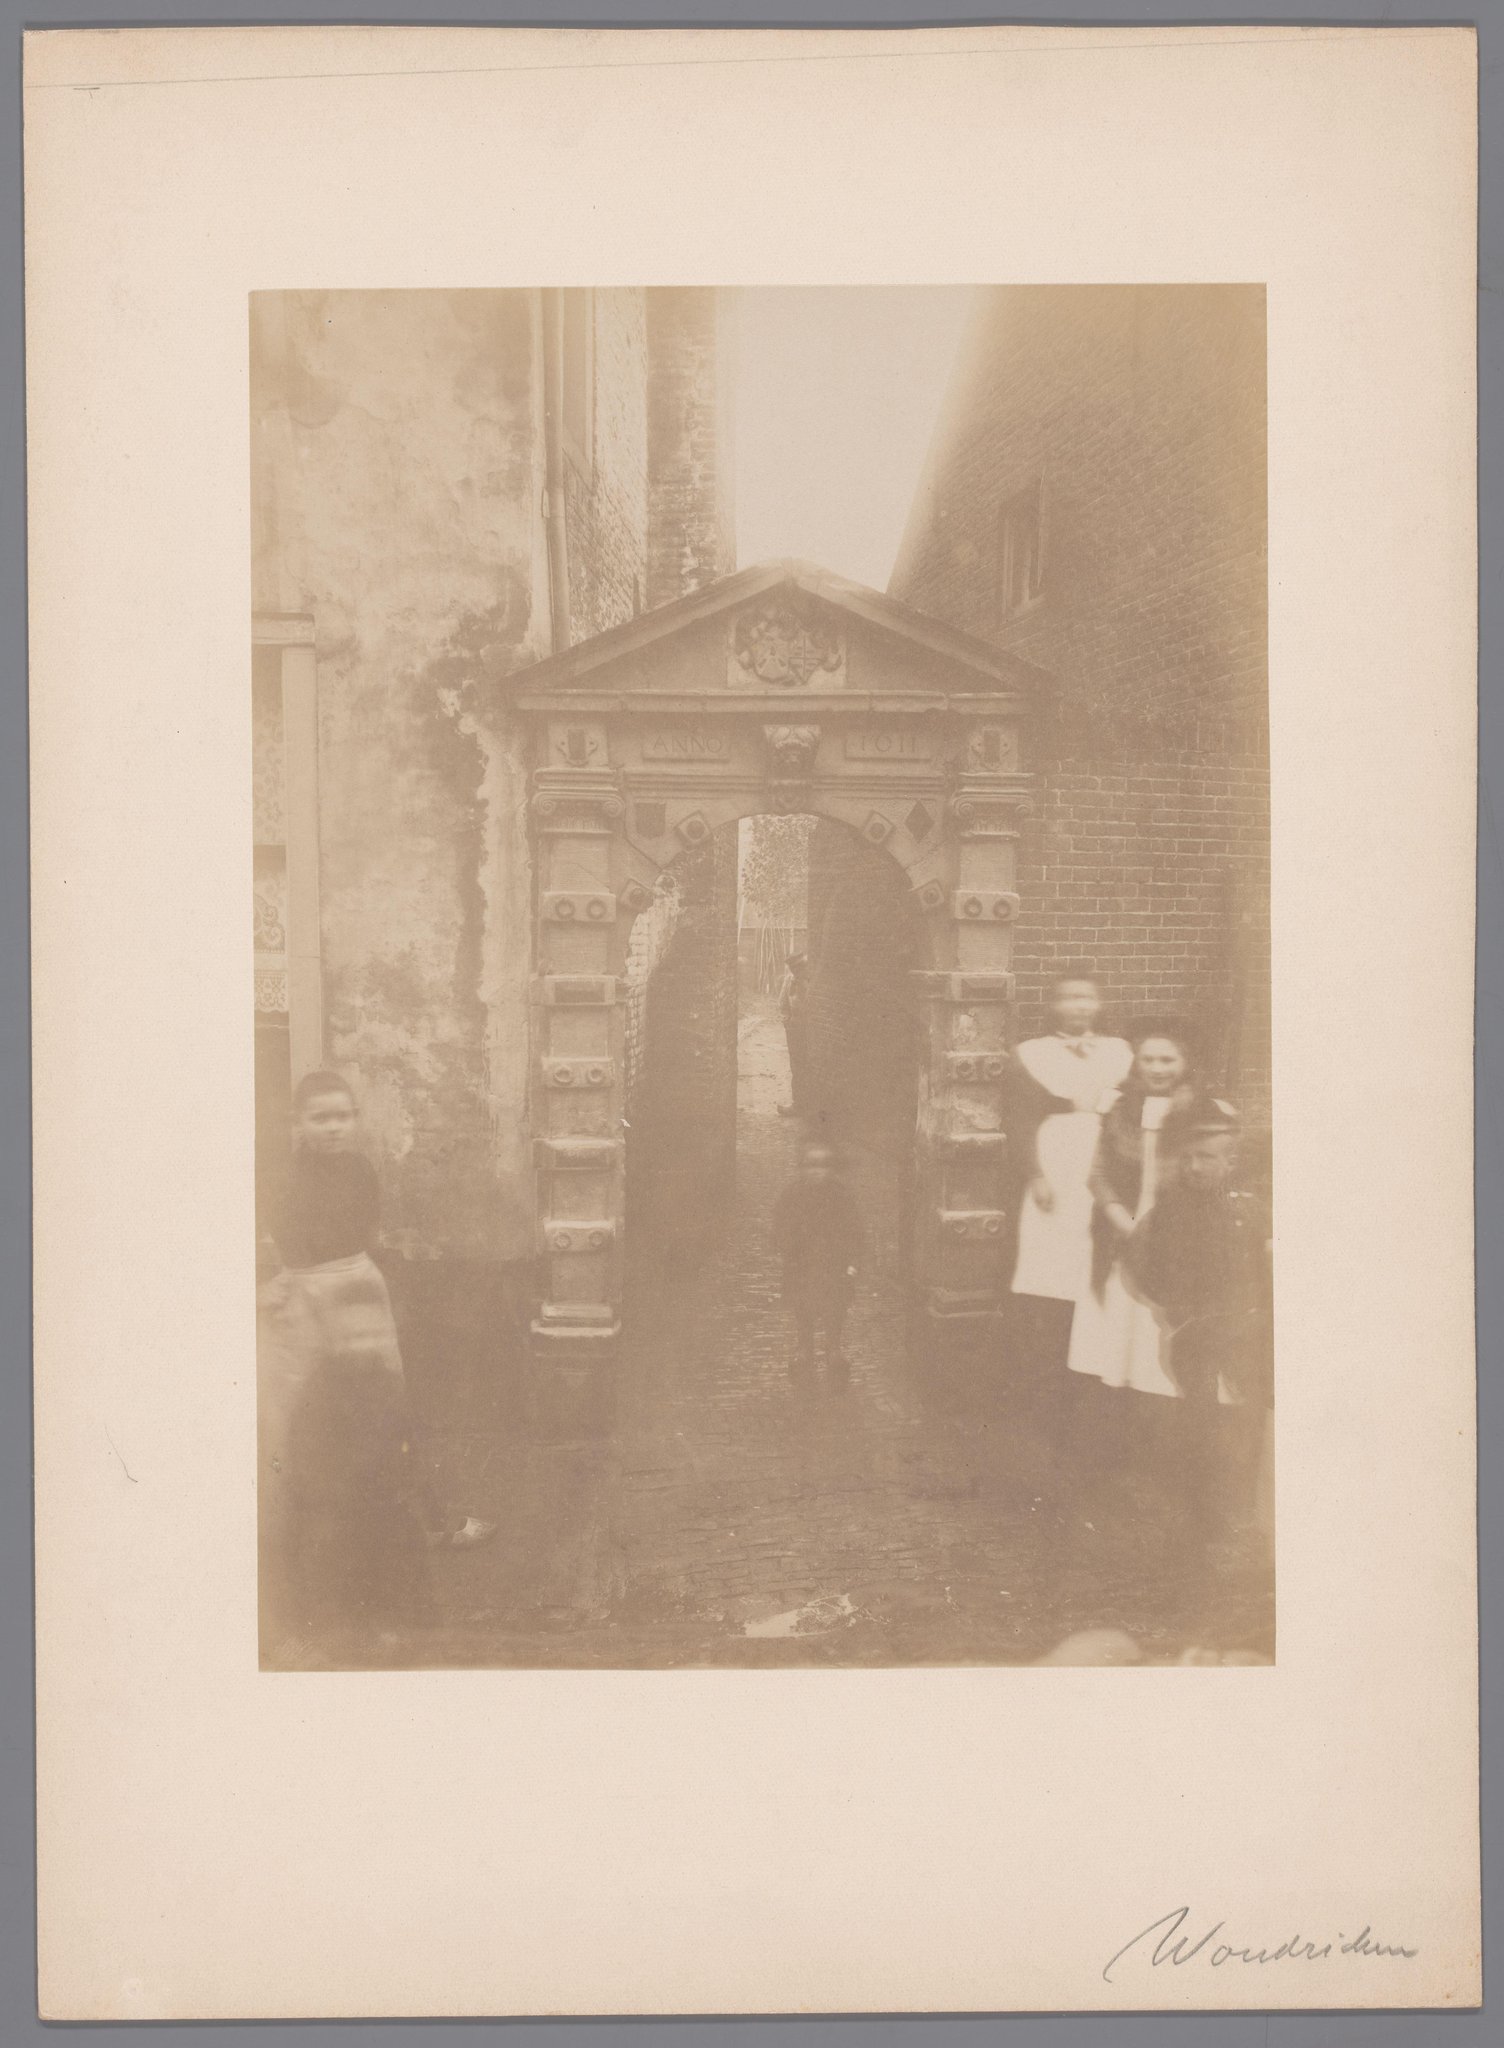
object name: photograph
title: De Witt's Poortje te Woudrichem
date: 1901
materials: cardboard, photographic support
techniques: albumen print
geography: woudrichem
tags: gate, entrance, woudrichem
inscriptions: annotation: ‘Woudrichem oct 1901 (N.B.)/ Poort van 1611 tegenover het gemeentehuis’, annotation: ‘Woudrichem’